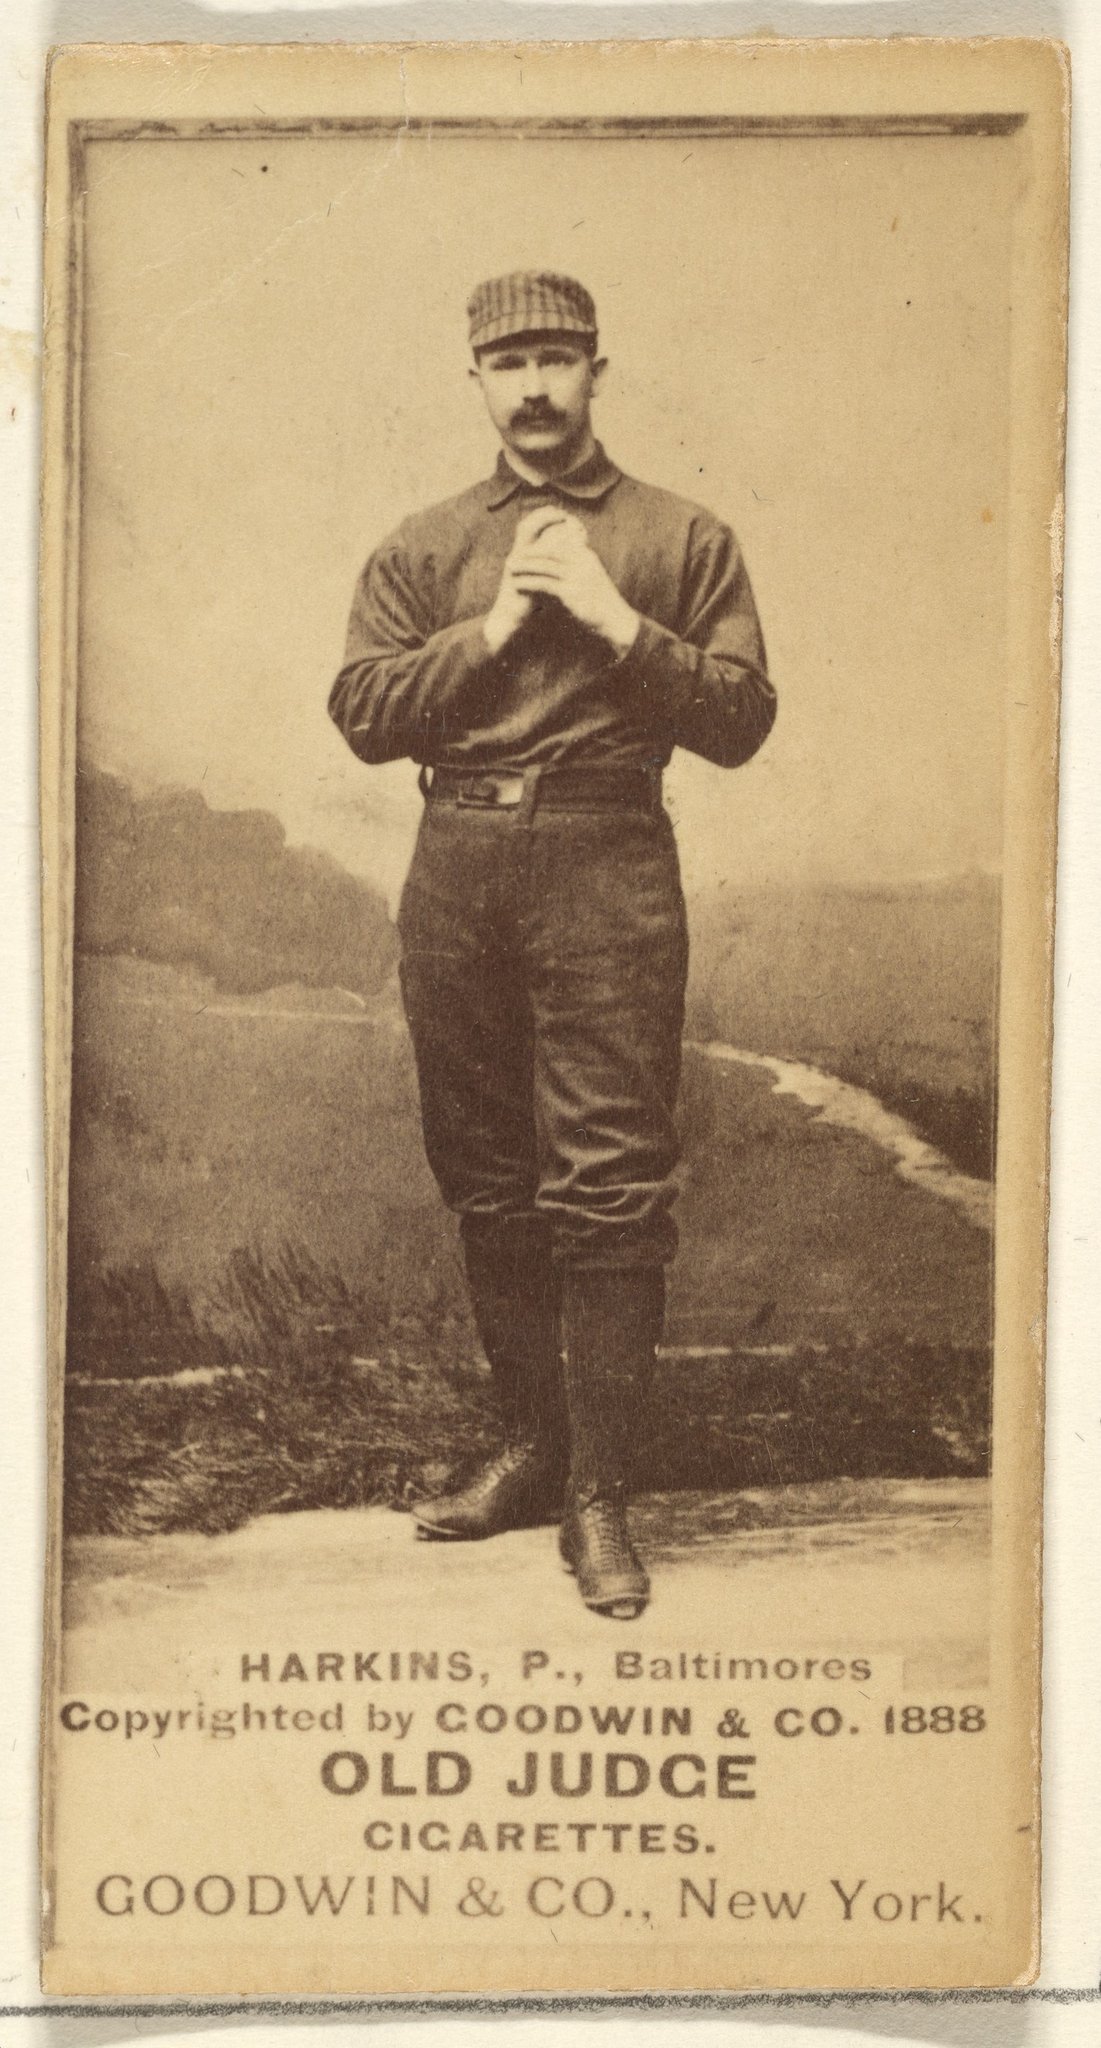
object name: baseball card, photograph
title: Harkins, Pitcher, Baltimore Orioles, from the Old Judge series (N172) for Old Judge Cigarettes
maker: goodwin & company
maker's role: publisher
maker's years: 1850-1950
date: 1888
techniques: albumen silver print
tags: men,portraits,baseball,athletes